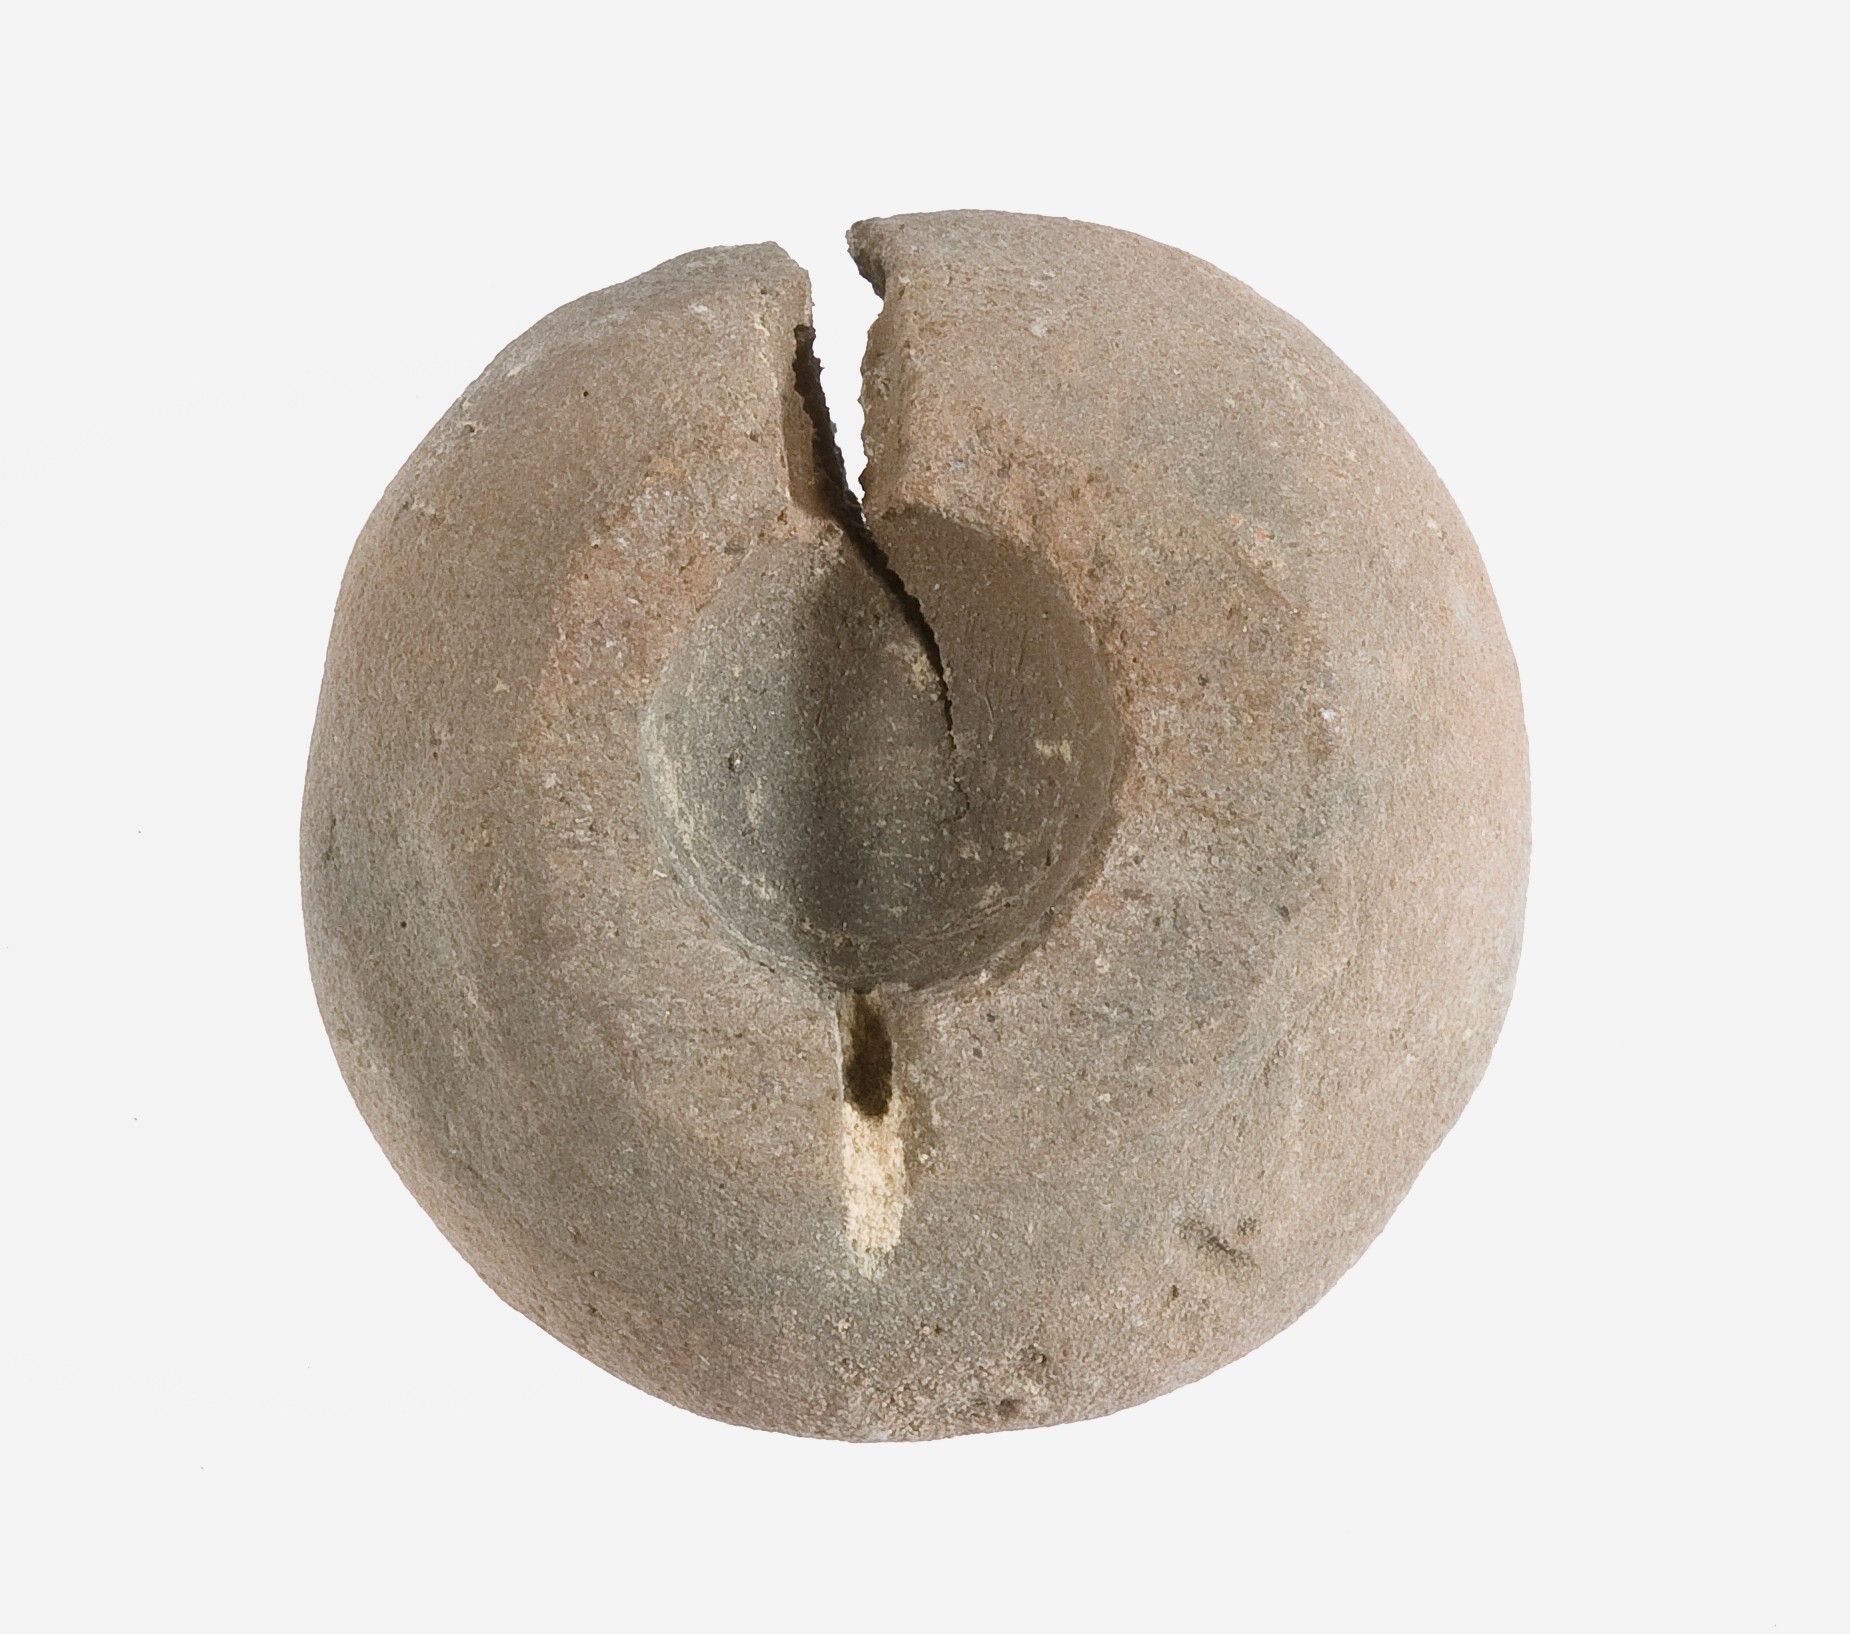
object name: mold, hemisphere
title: Mold for a Hemispherical Boss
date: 1390-1352 BCE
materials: pottery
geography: egypt